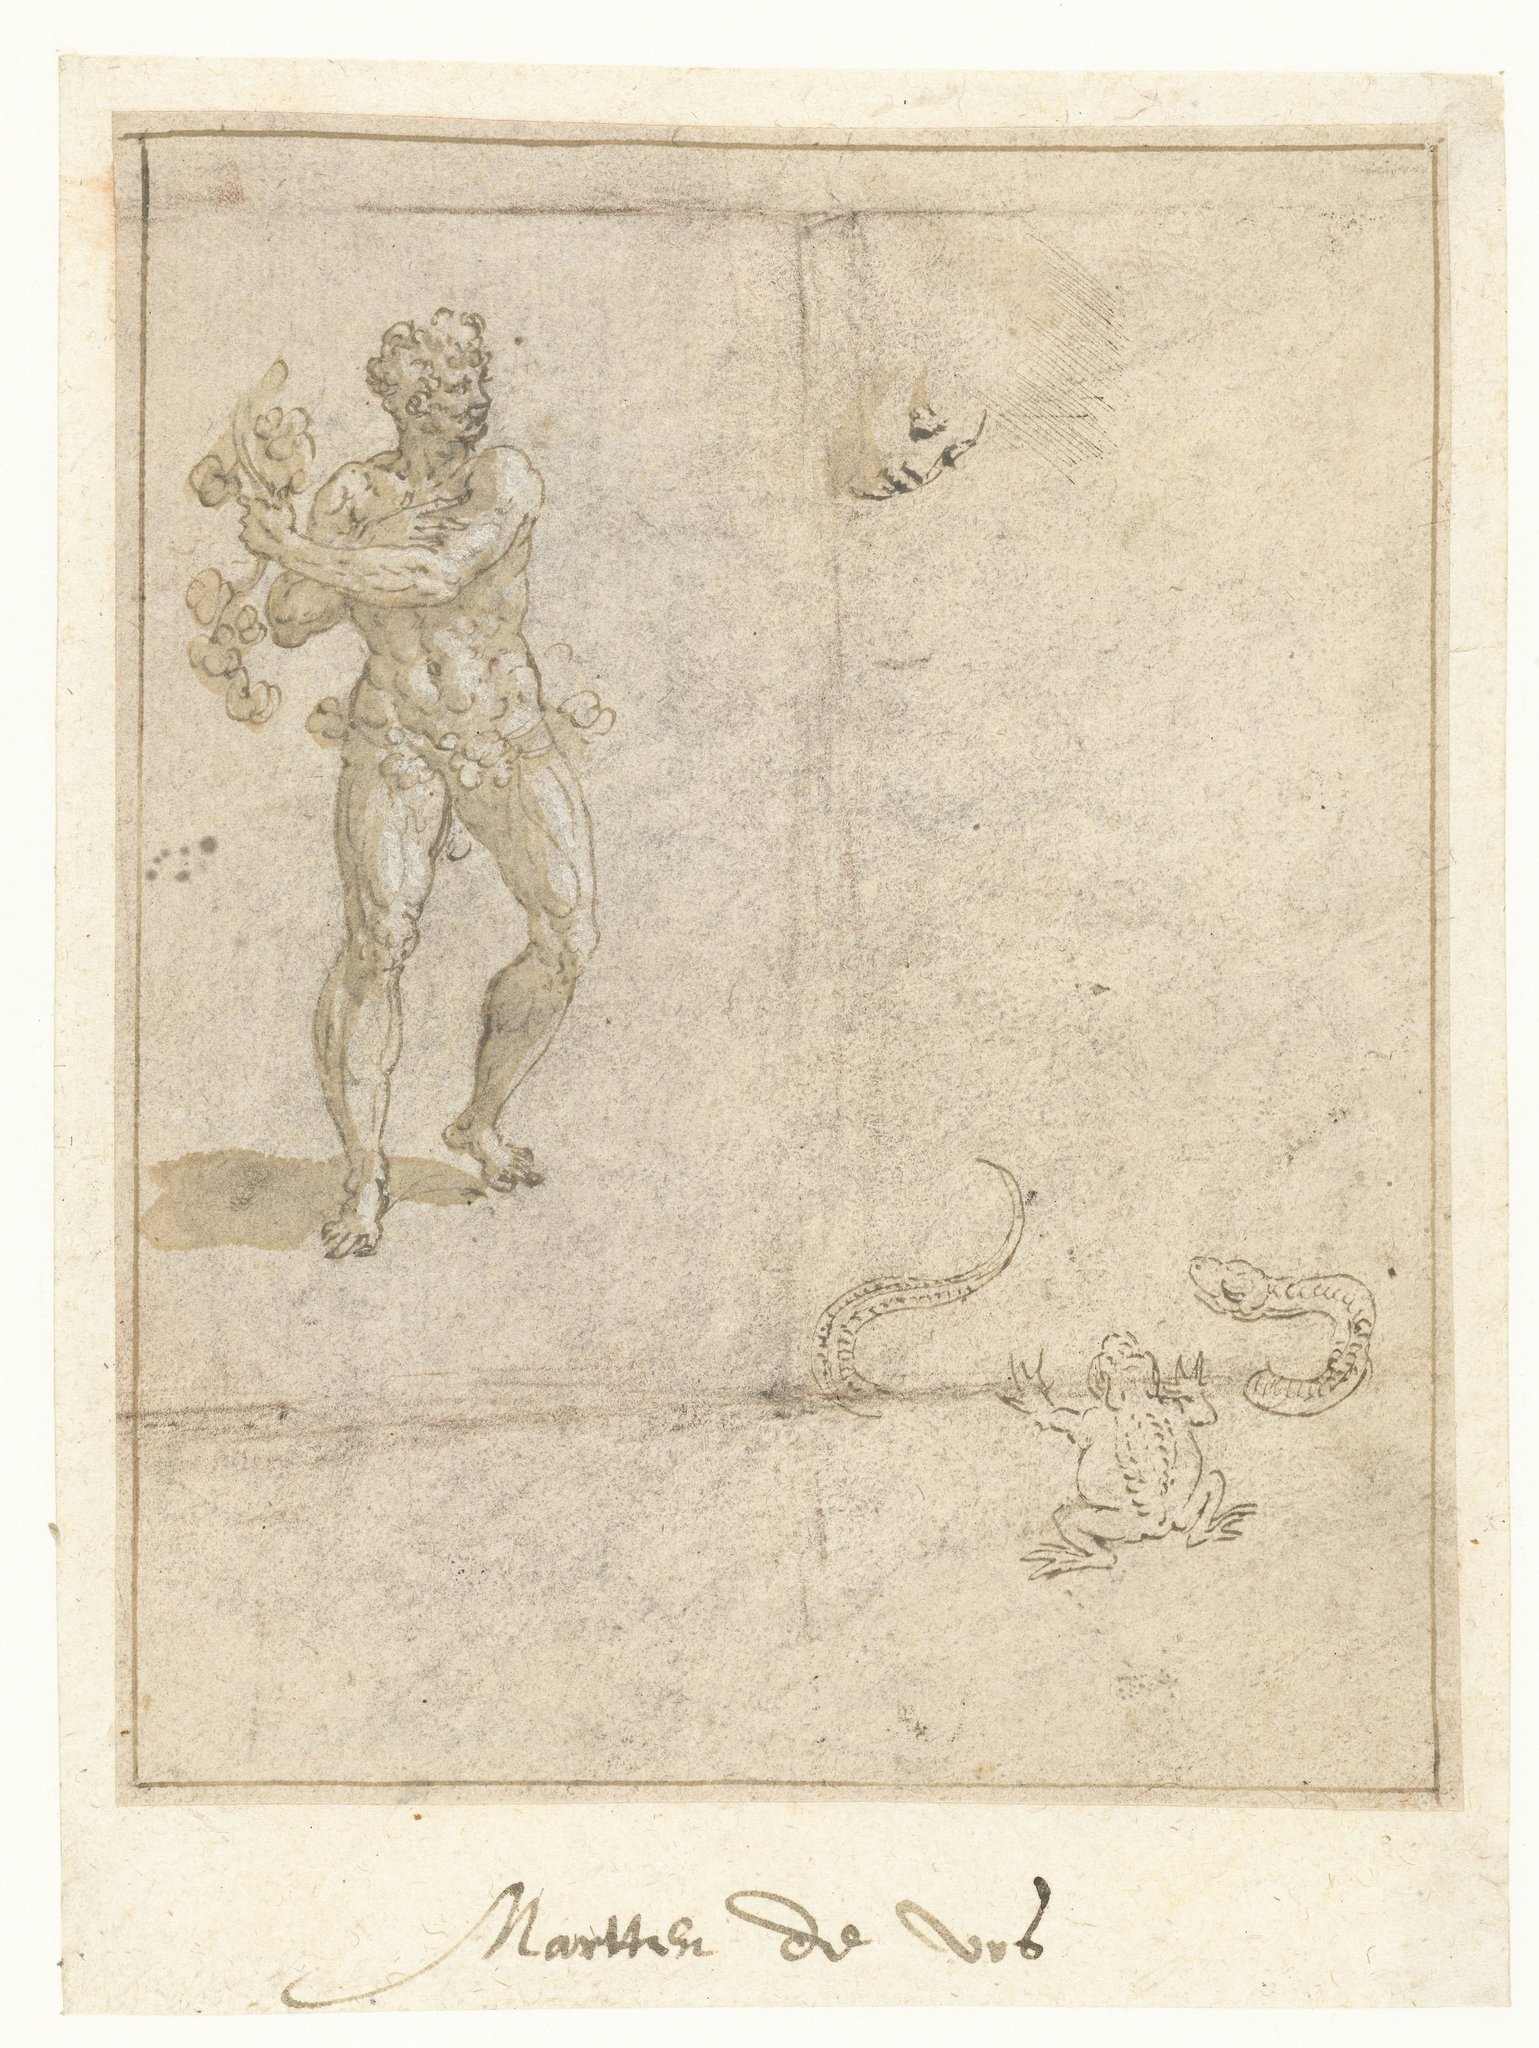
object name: drawing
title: Staande man, slang en een kikker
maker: maerten de vos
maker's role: draughtsman, painter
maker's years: 1532-1603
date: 1542-1603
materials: ink, paper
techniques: brush, pen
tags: tailless amphibians: frog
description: Schets van een staande man met een wijnrank om zijn middel en in zijn rechterhand, en schetsen van een slang en een kikker.